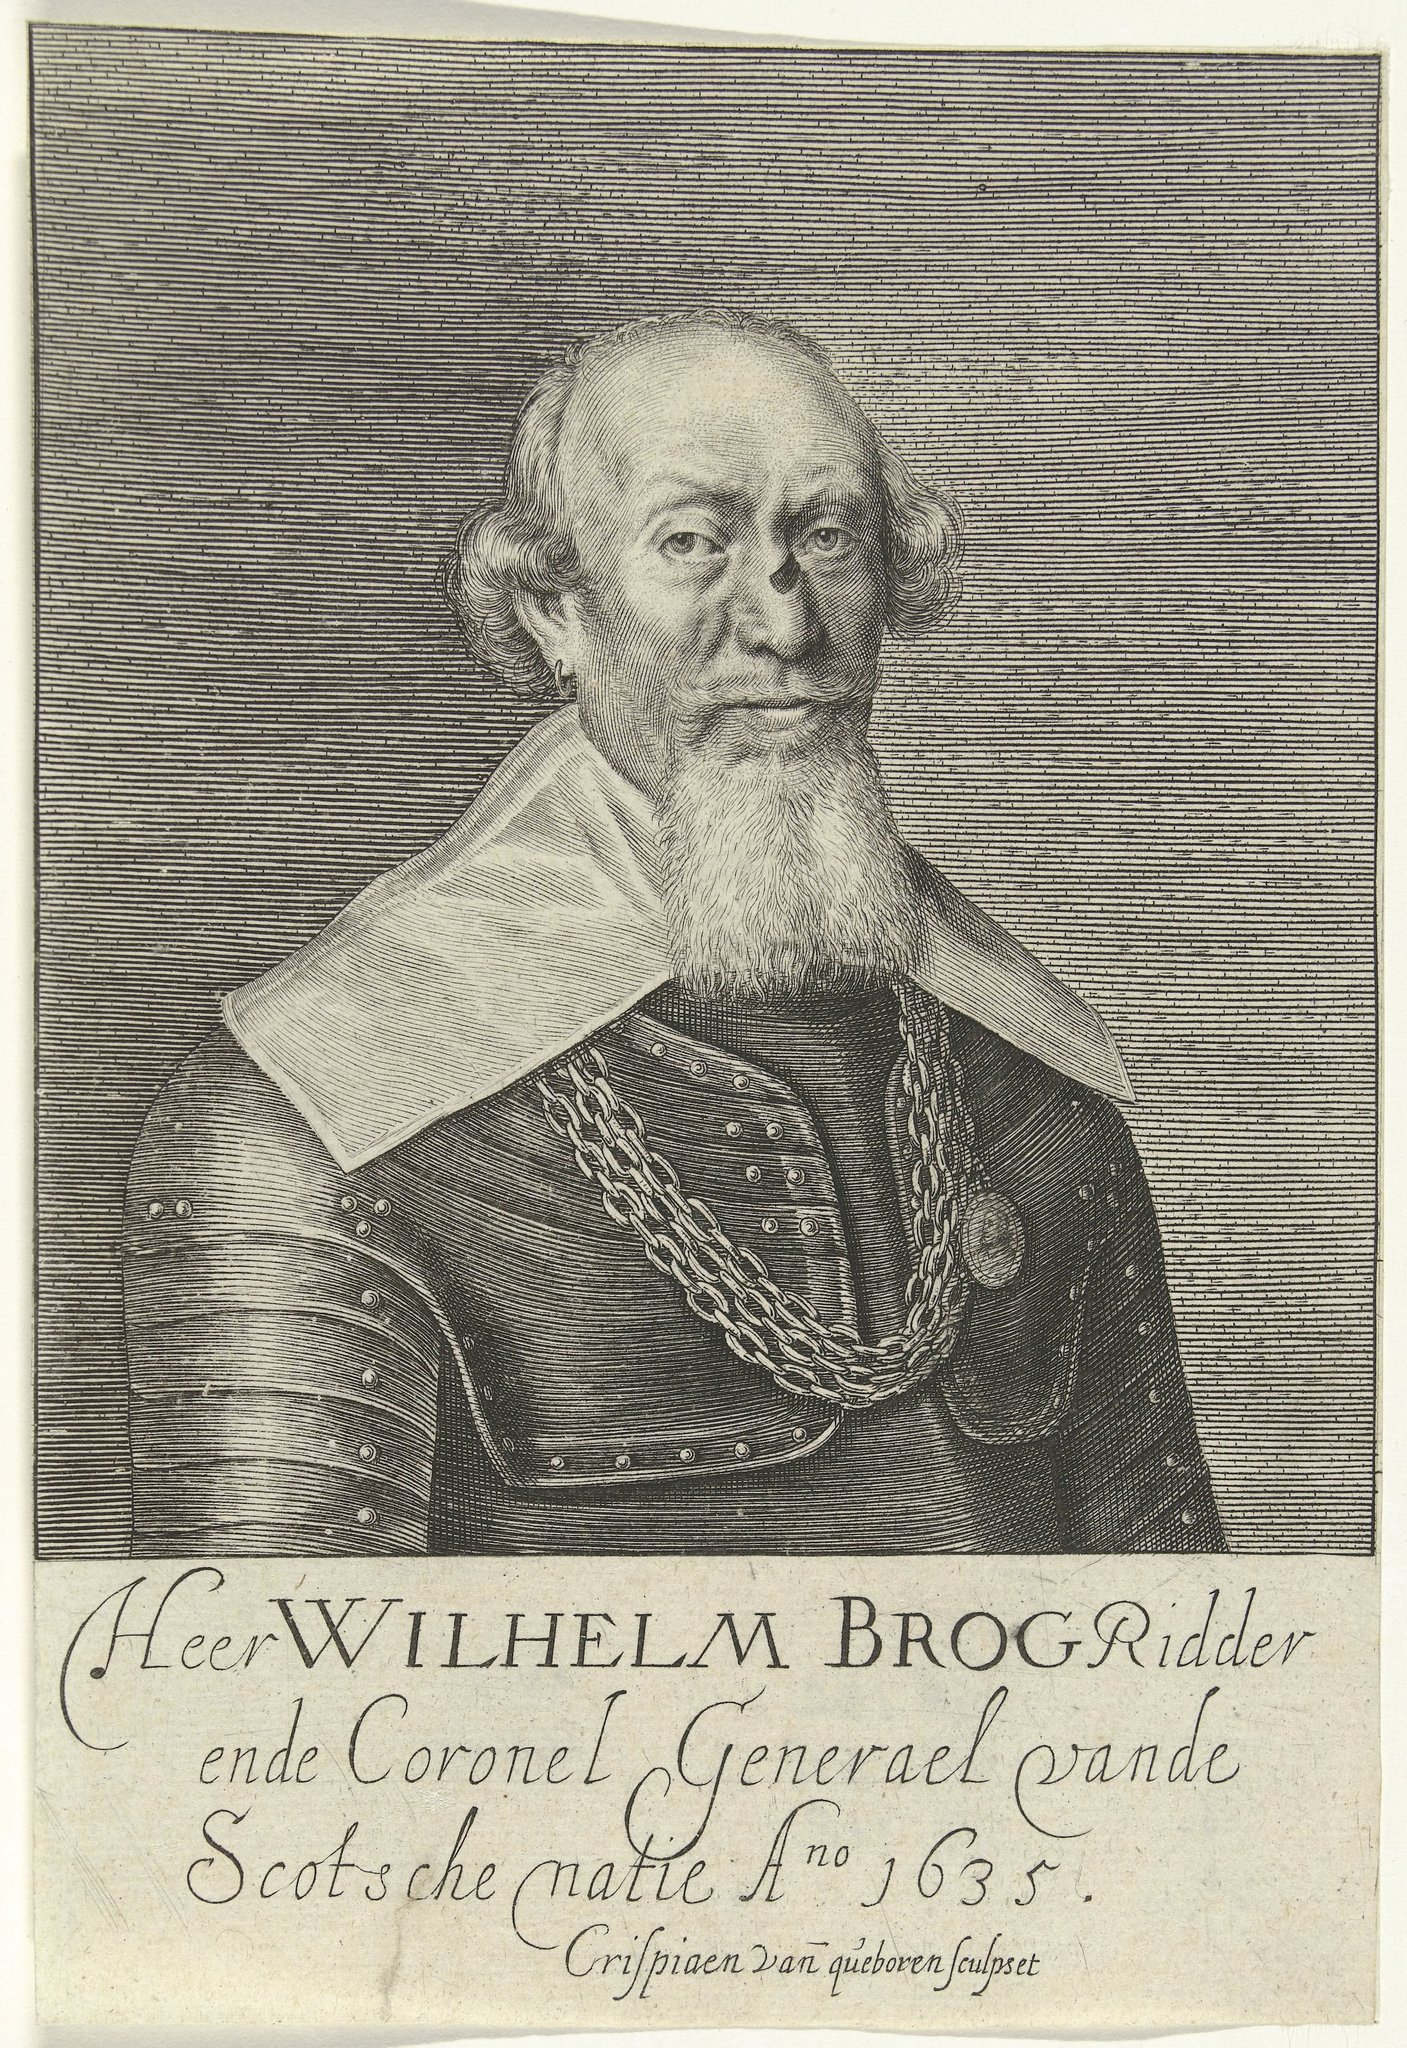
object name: print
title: Portret van Sir William Brog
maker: crispijn van den queborn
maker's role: print maker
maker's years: 1595-1652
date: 1635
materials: paper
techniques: engraving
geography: the hague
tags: sir william brog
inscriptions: collector's mark: Lugt 964, collector's mark: Lugt 2228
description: Portret van Sir William Brog, vanaf 1588 kolonel bij de Schotse brigades in Staatse dienst. Brog heeft een verwonding op zijn neus.